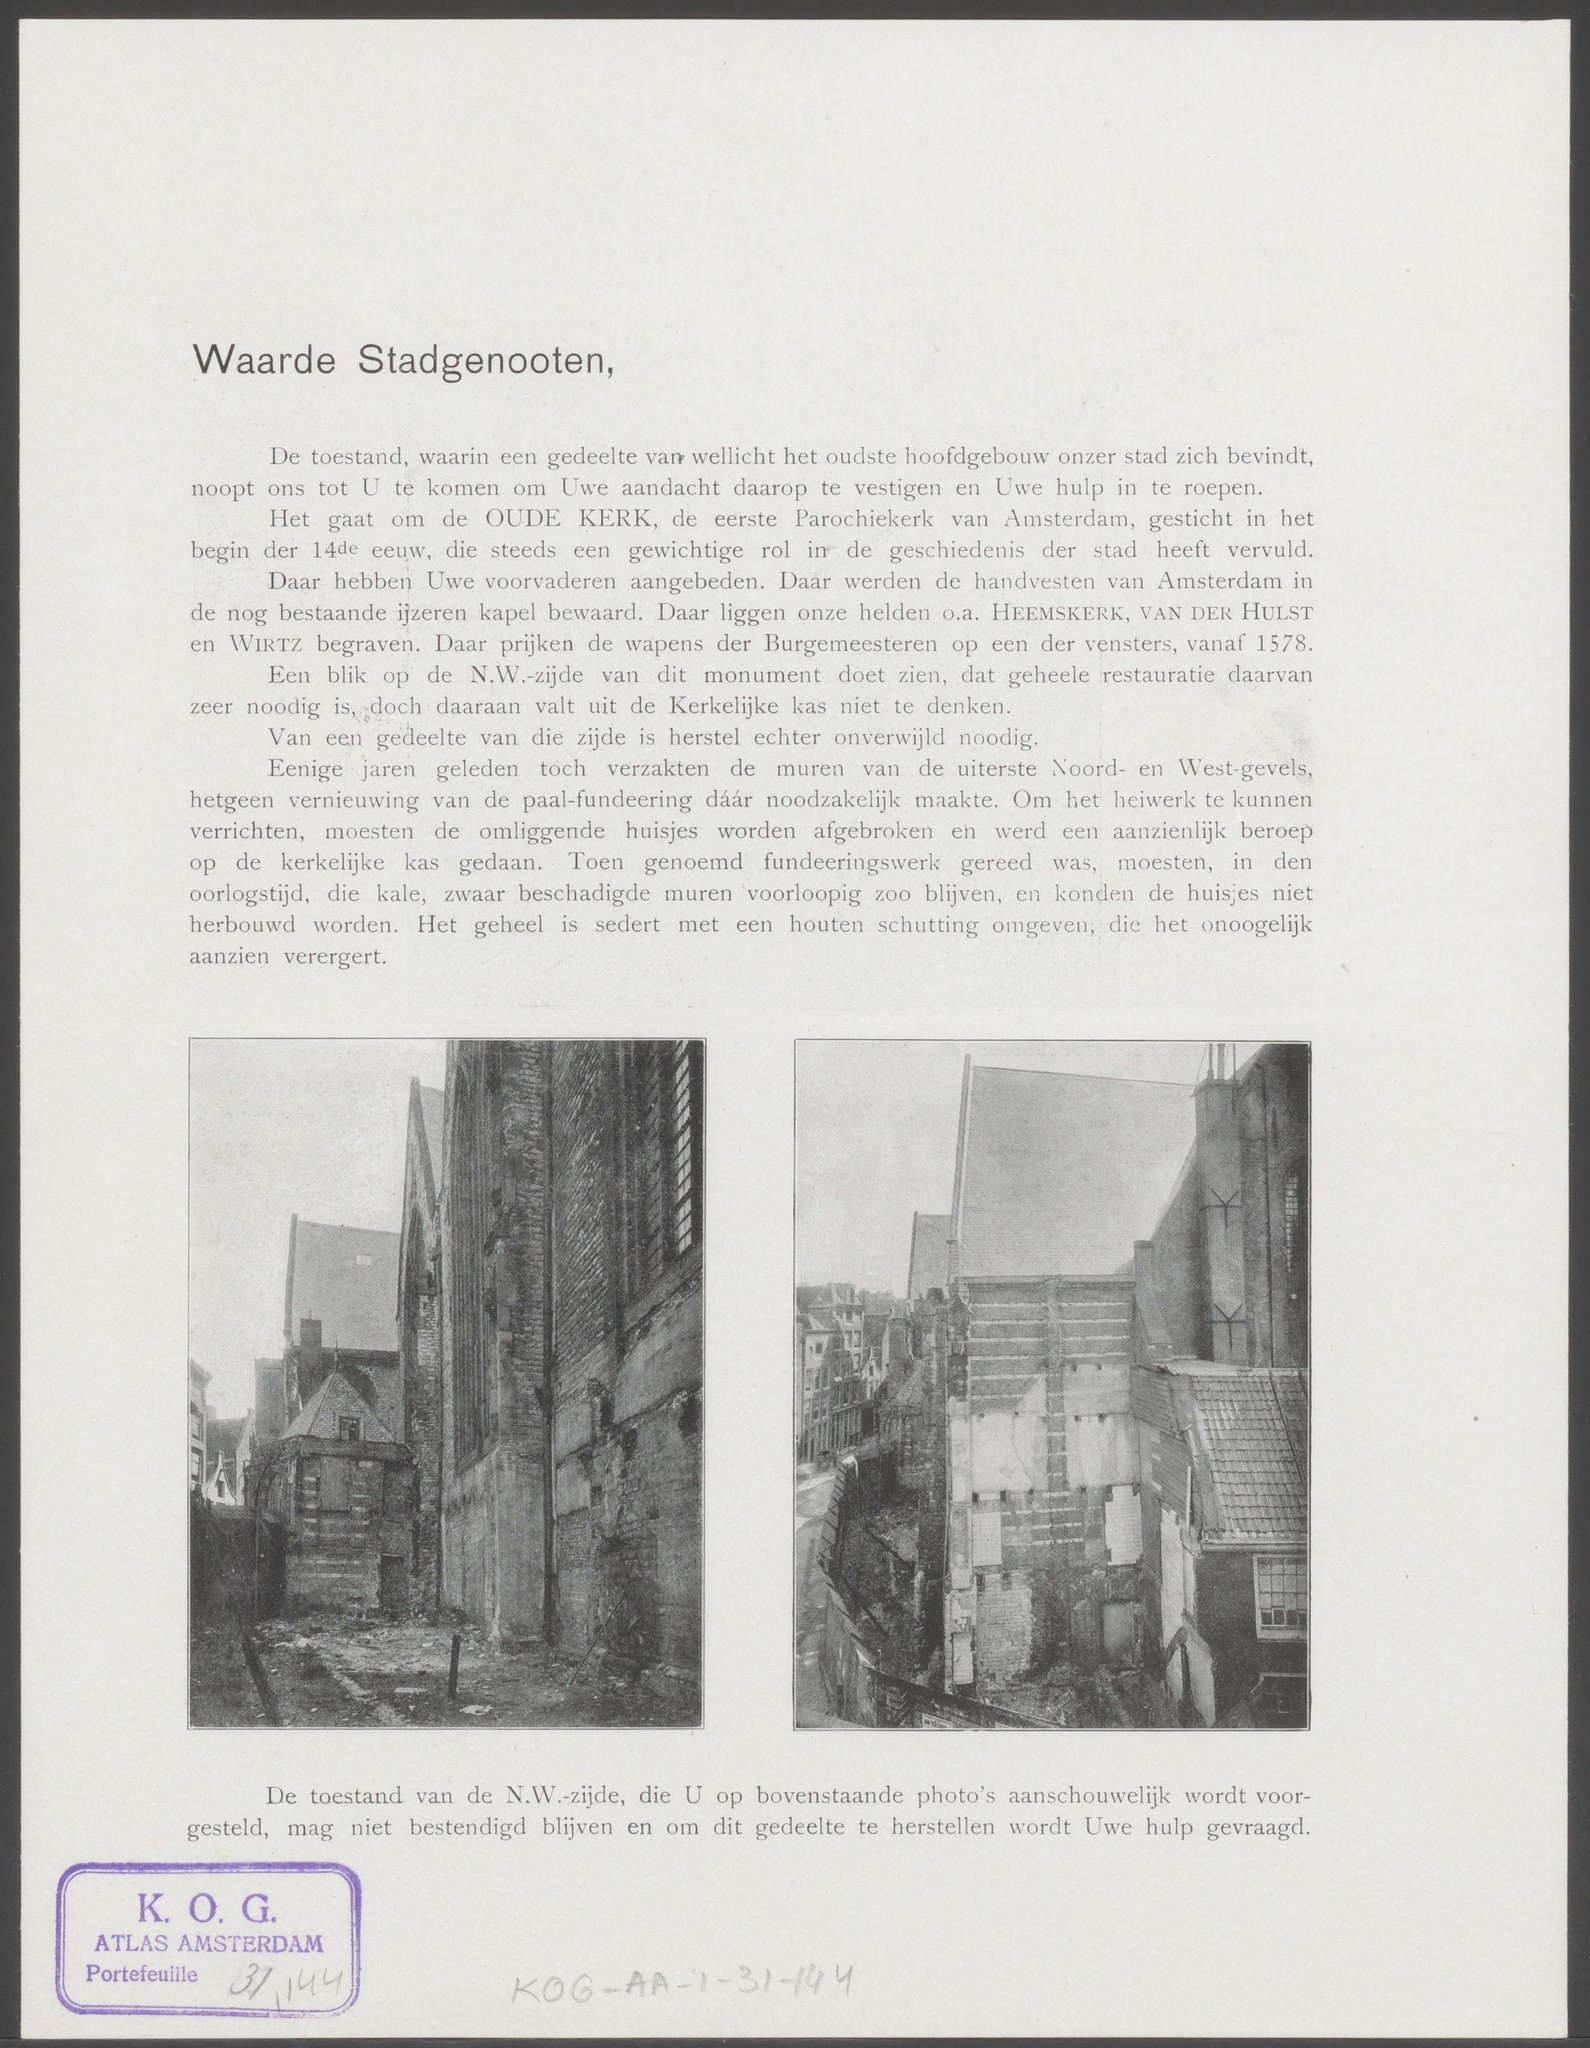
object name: photomechanical print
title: Verzoek om een bijdrage voor de restauratie van de Oude Kerk te Amsterdam, 1920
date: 1903-1920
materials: paper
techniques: letterpress printing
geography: amsterdam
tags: building of church, parts of church exterior and annexes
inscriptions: collector's mark: ‘31.144’ Lugt 1641b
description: Verzoek aan Amsterdammers om een financiële bijdrage ten behoeve van restauratiewerkzaamheden, namens de Kerkelijke Commissie. Bestaande uit twee pagina's, met drie autotypieën van de noord- en westgevels van de Oude Kerk. Onderwerpsrubriek binnen de Atlas Amsterdam: Kerkwezen: Hervormde Gemeente: Oude Kerk van binnen.